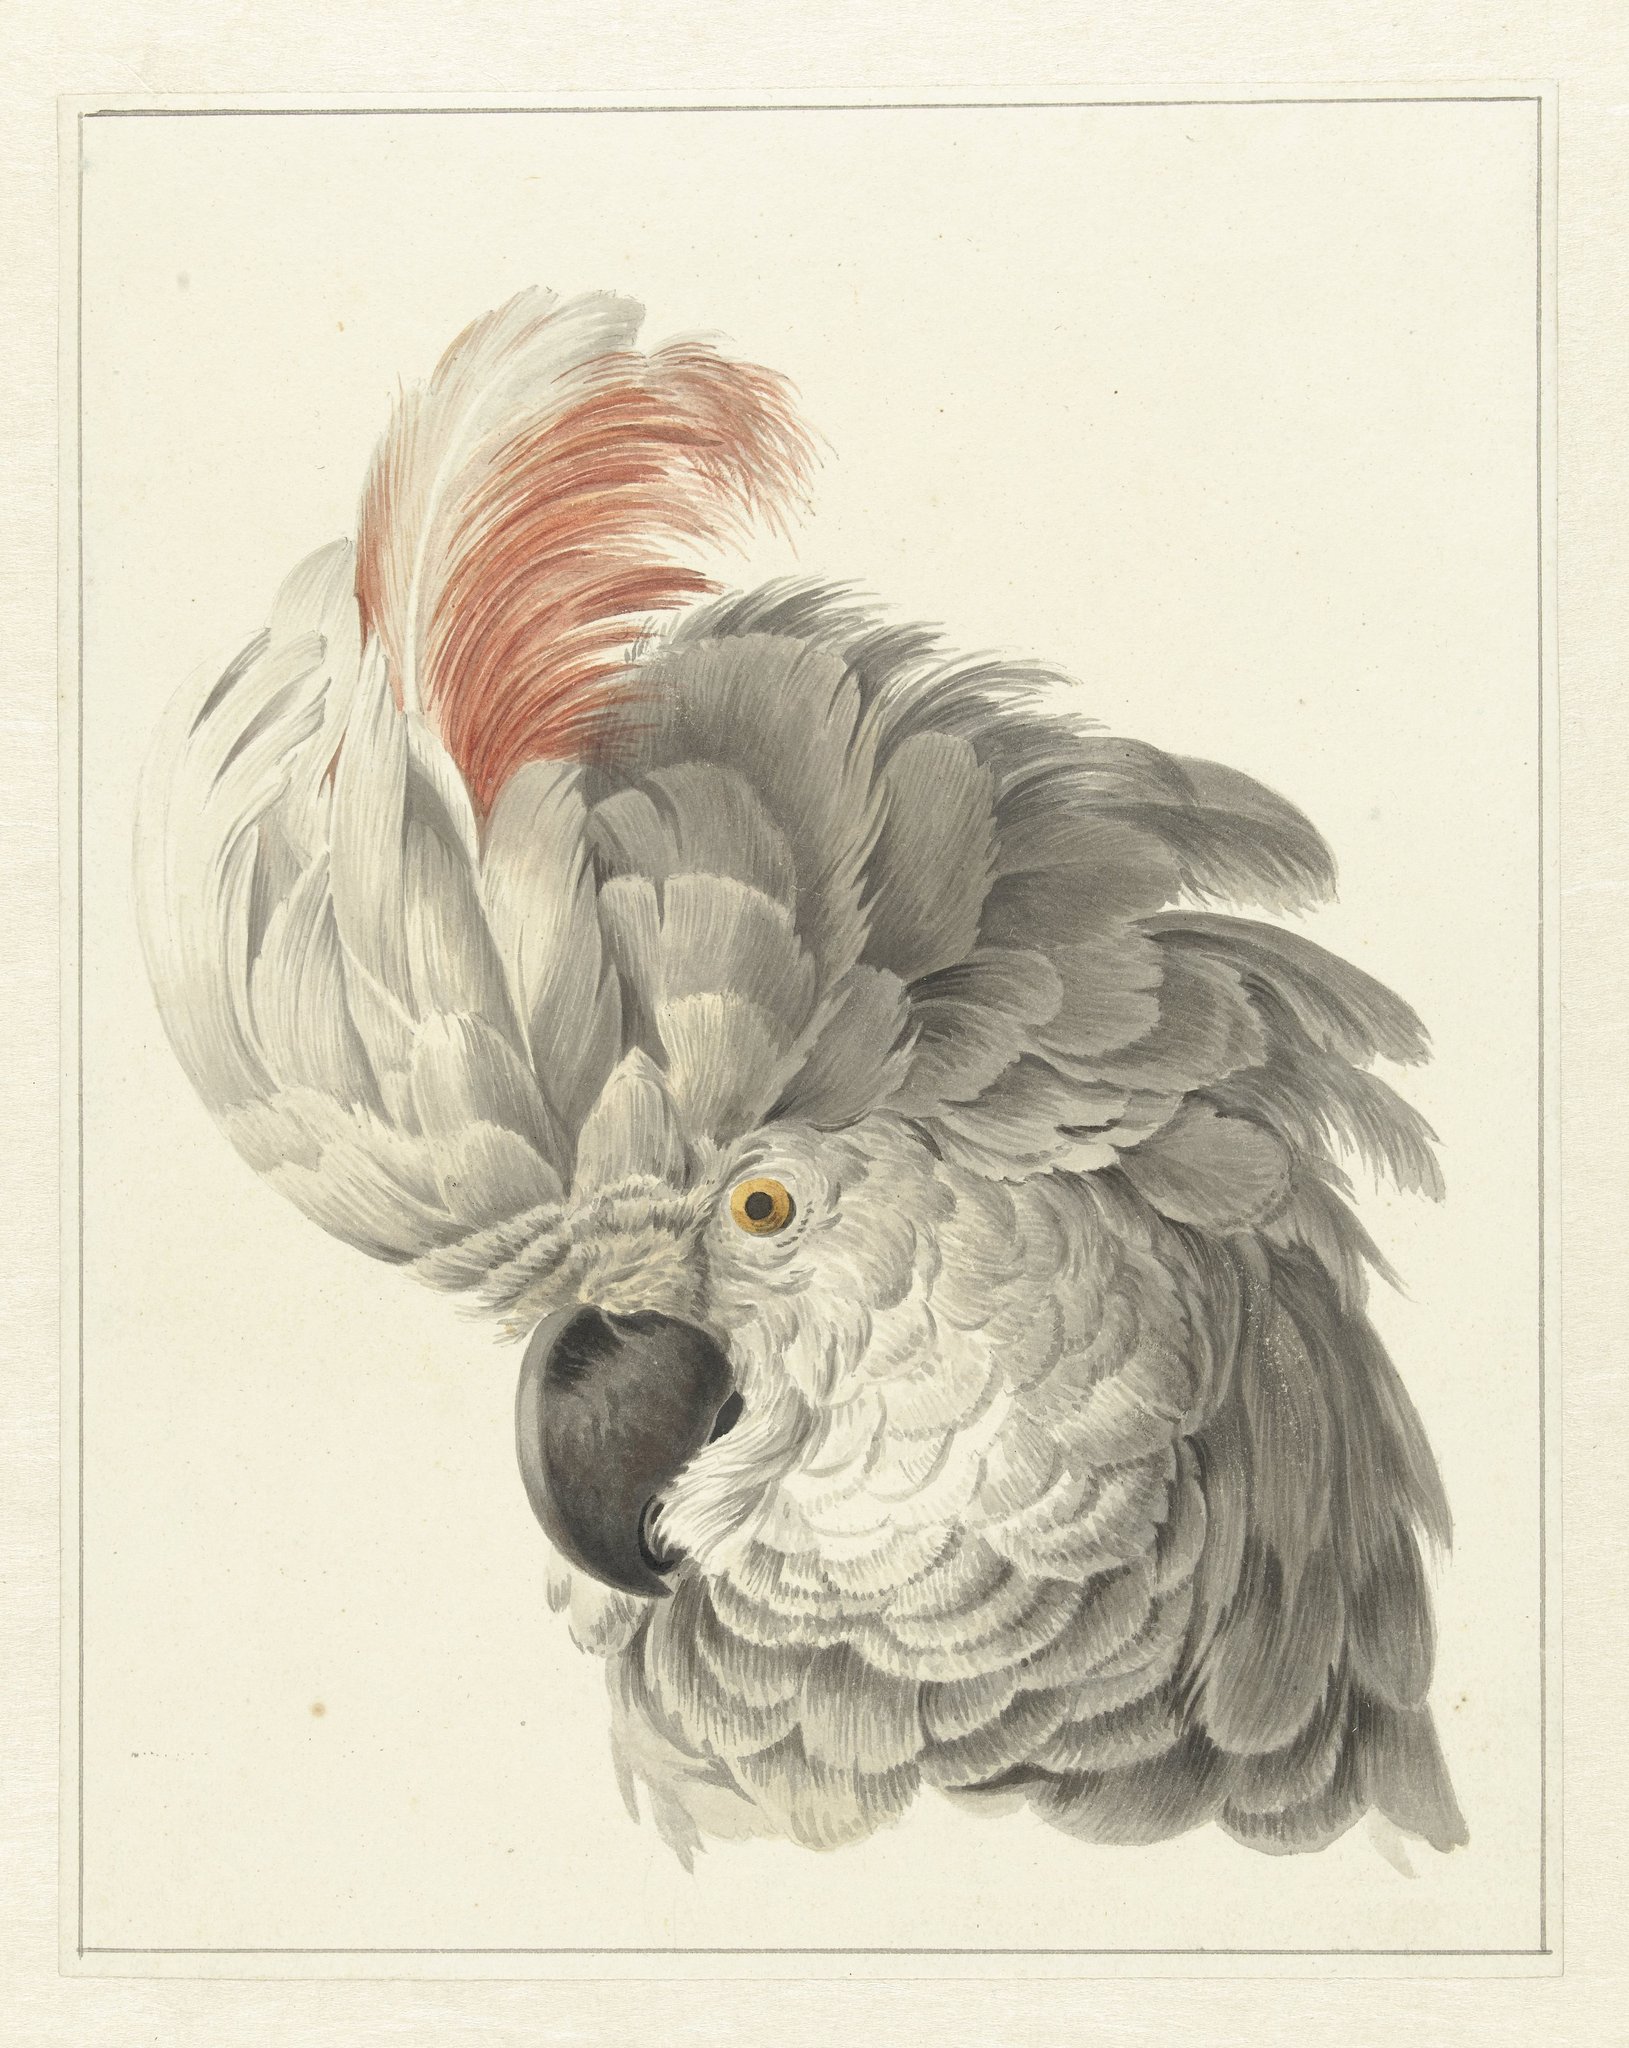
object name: drawing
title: Kop van een kaketoe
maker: aert schouman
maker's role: draughtsman, painter, print maker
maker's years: 1710-1792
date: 1725-1792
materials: paper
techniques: aquarelle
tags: ornamental birds: cockatoo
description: RP-T-1905-220 t/m 254: Vijfendertig Tekeningen met verschillende vogel- en apensoorten. Op één ervan: Histoire naturelle de viseaux d'Afrique par Francóis Le voillant Exemple. soignees.